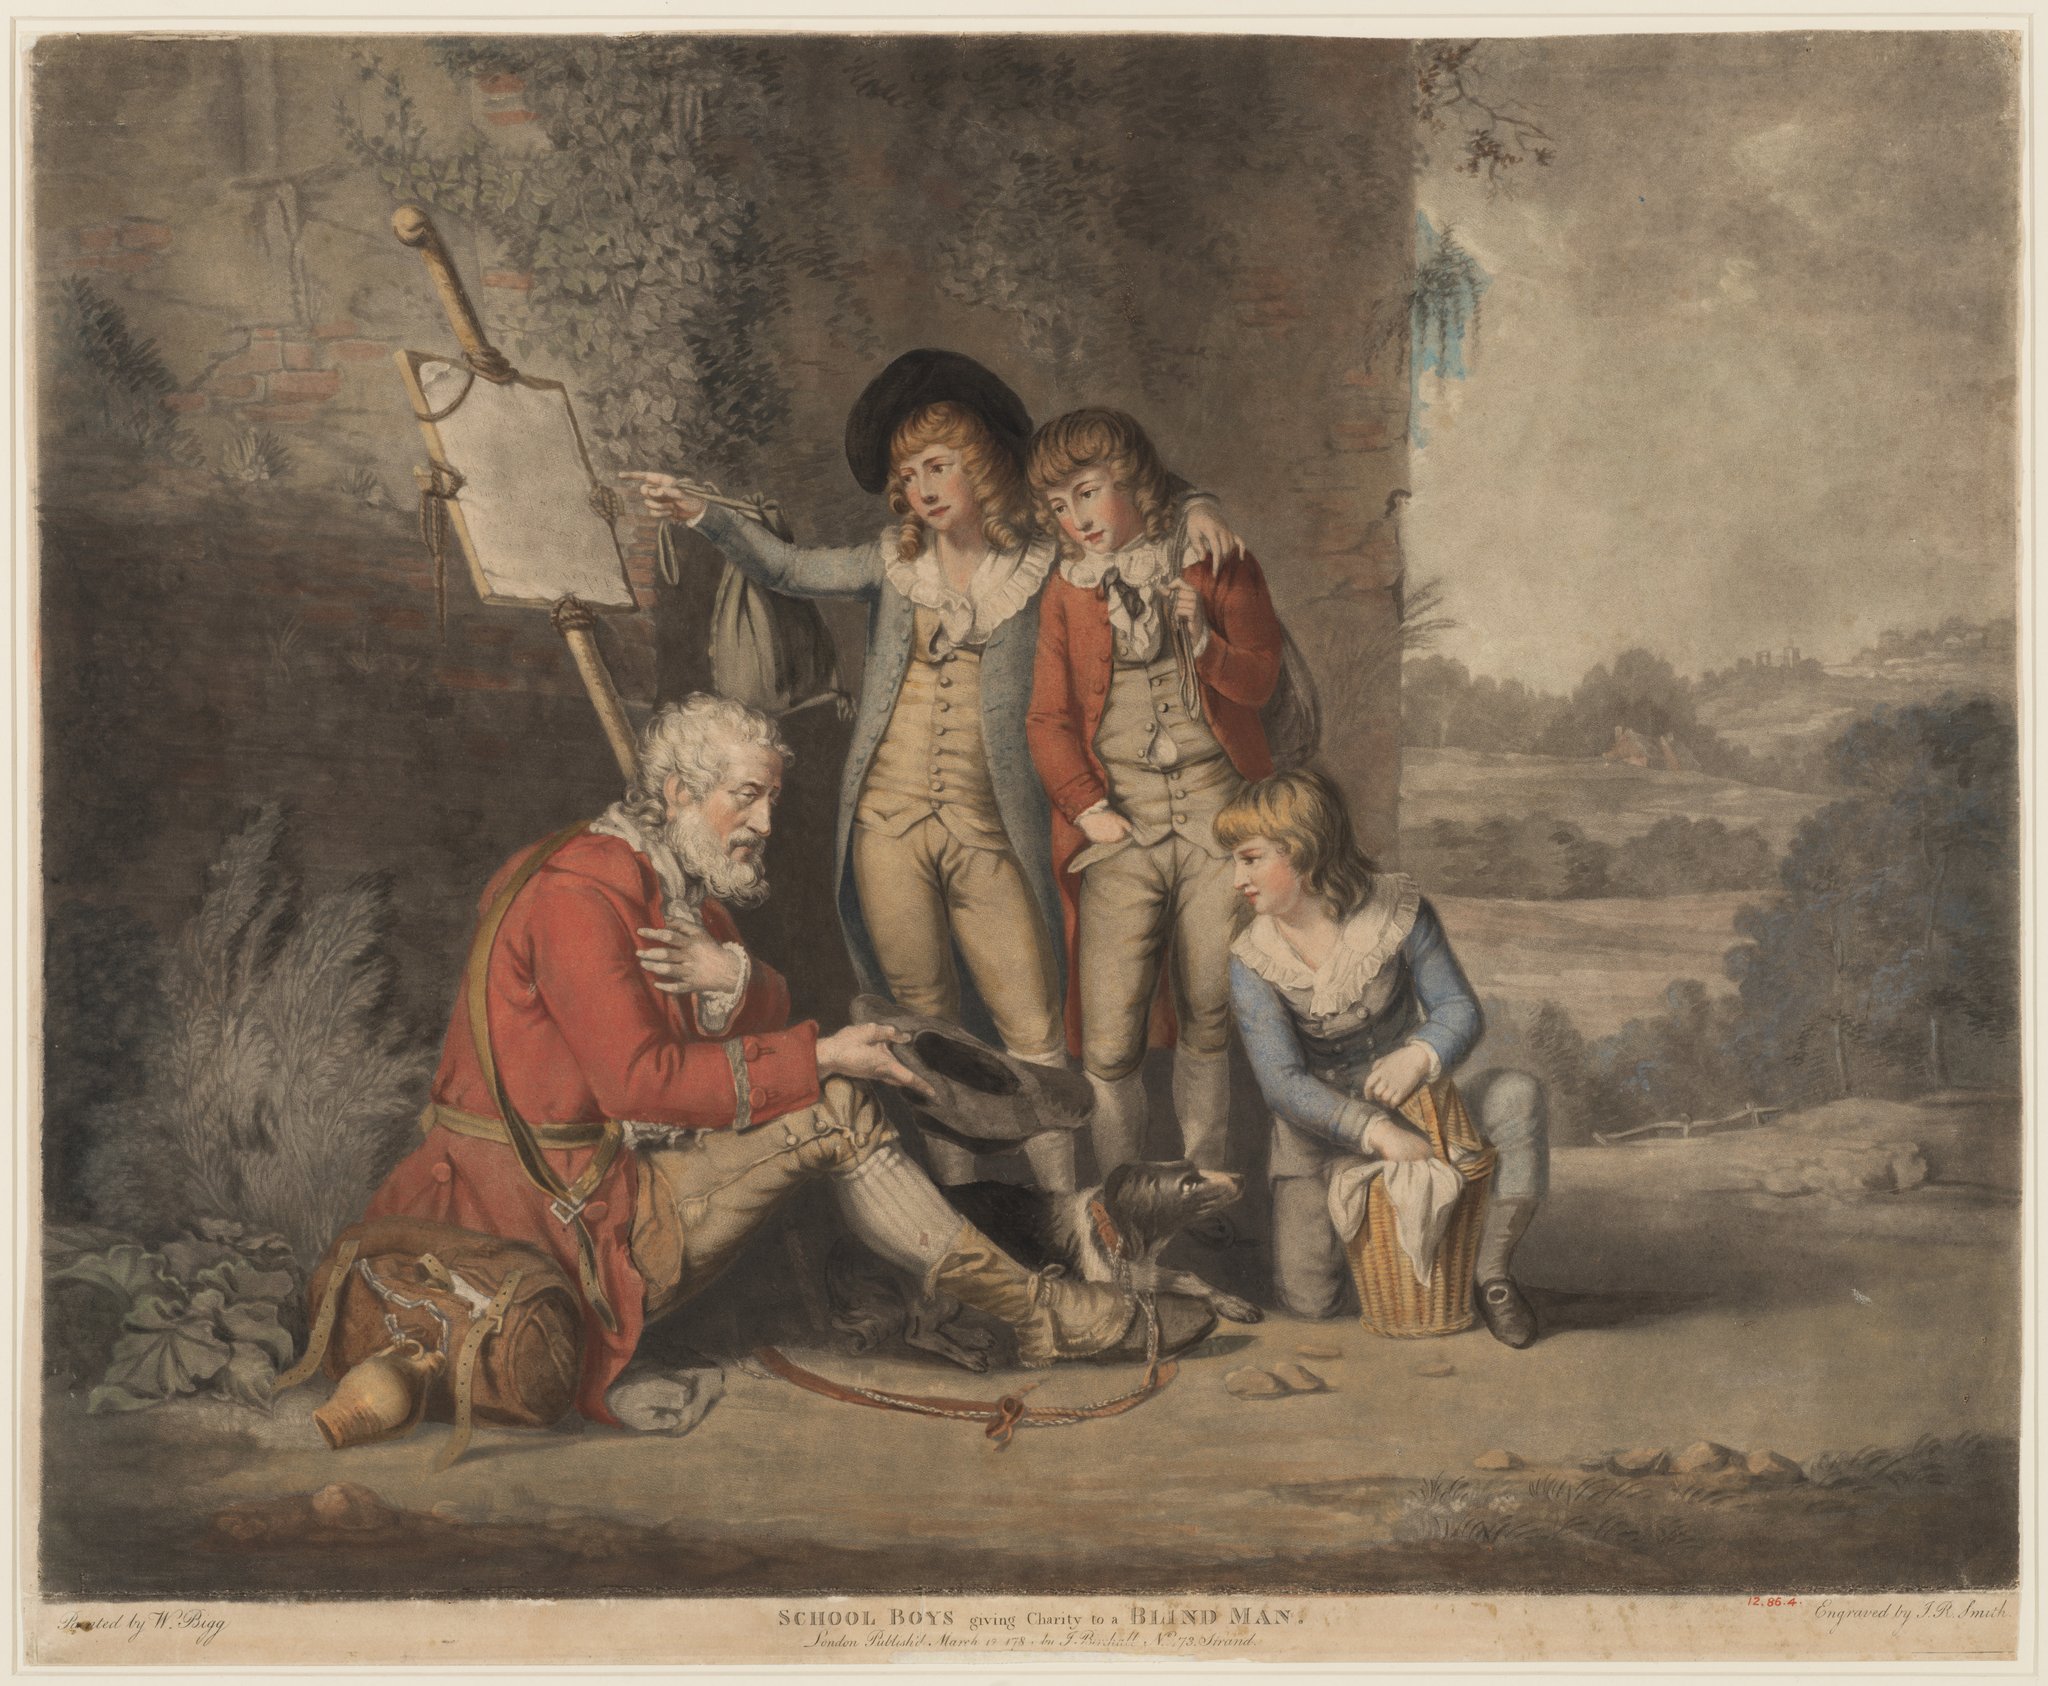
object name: print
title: Schoolboys Giving Charity to a Blind Man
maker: john raphael smith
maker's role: artist and engraver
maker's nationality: british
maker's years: 1751-1812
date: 1781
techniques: hand coloring, mezzotint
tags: boys,men,dogs